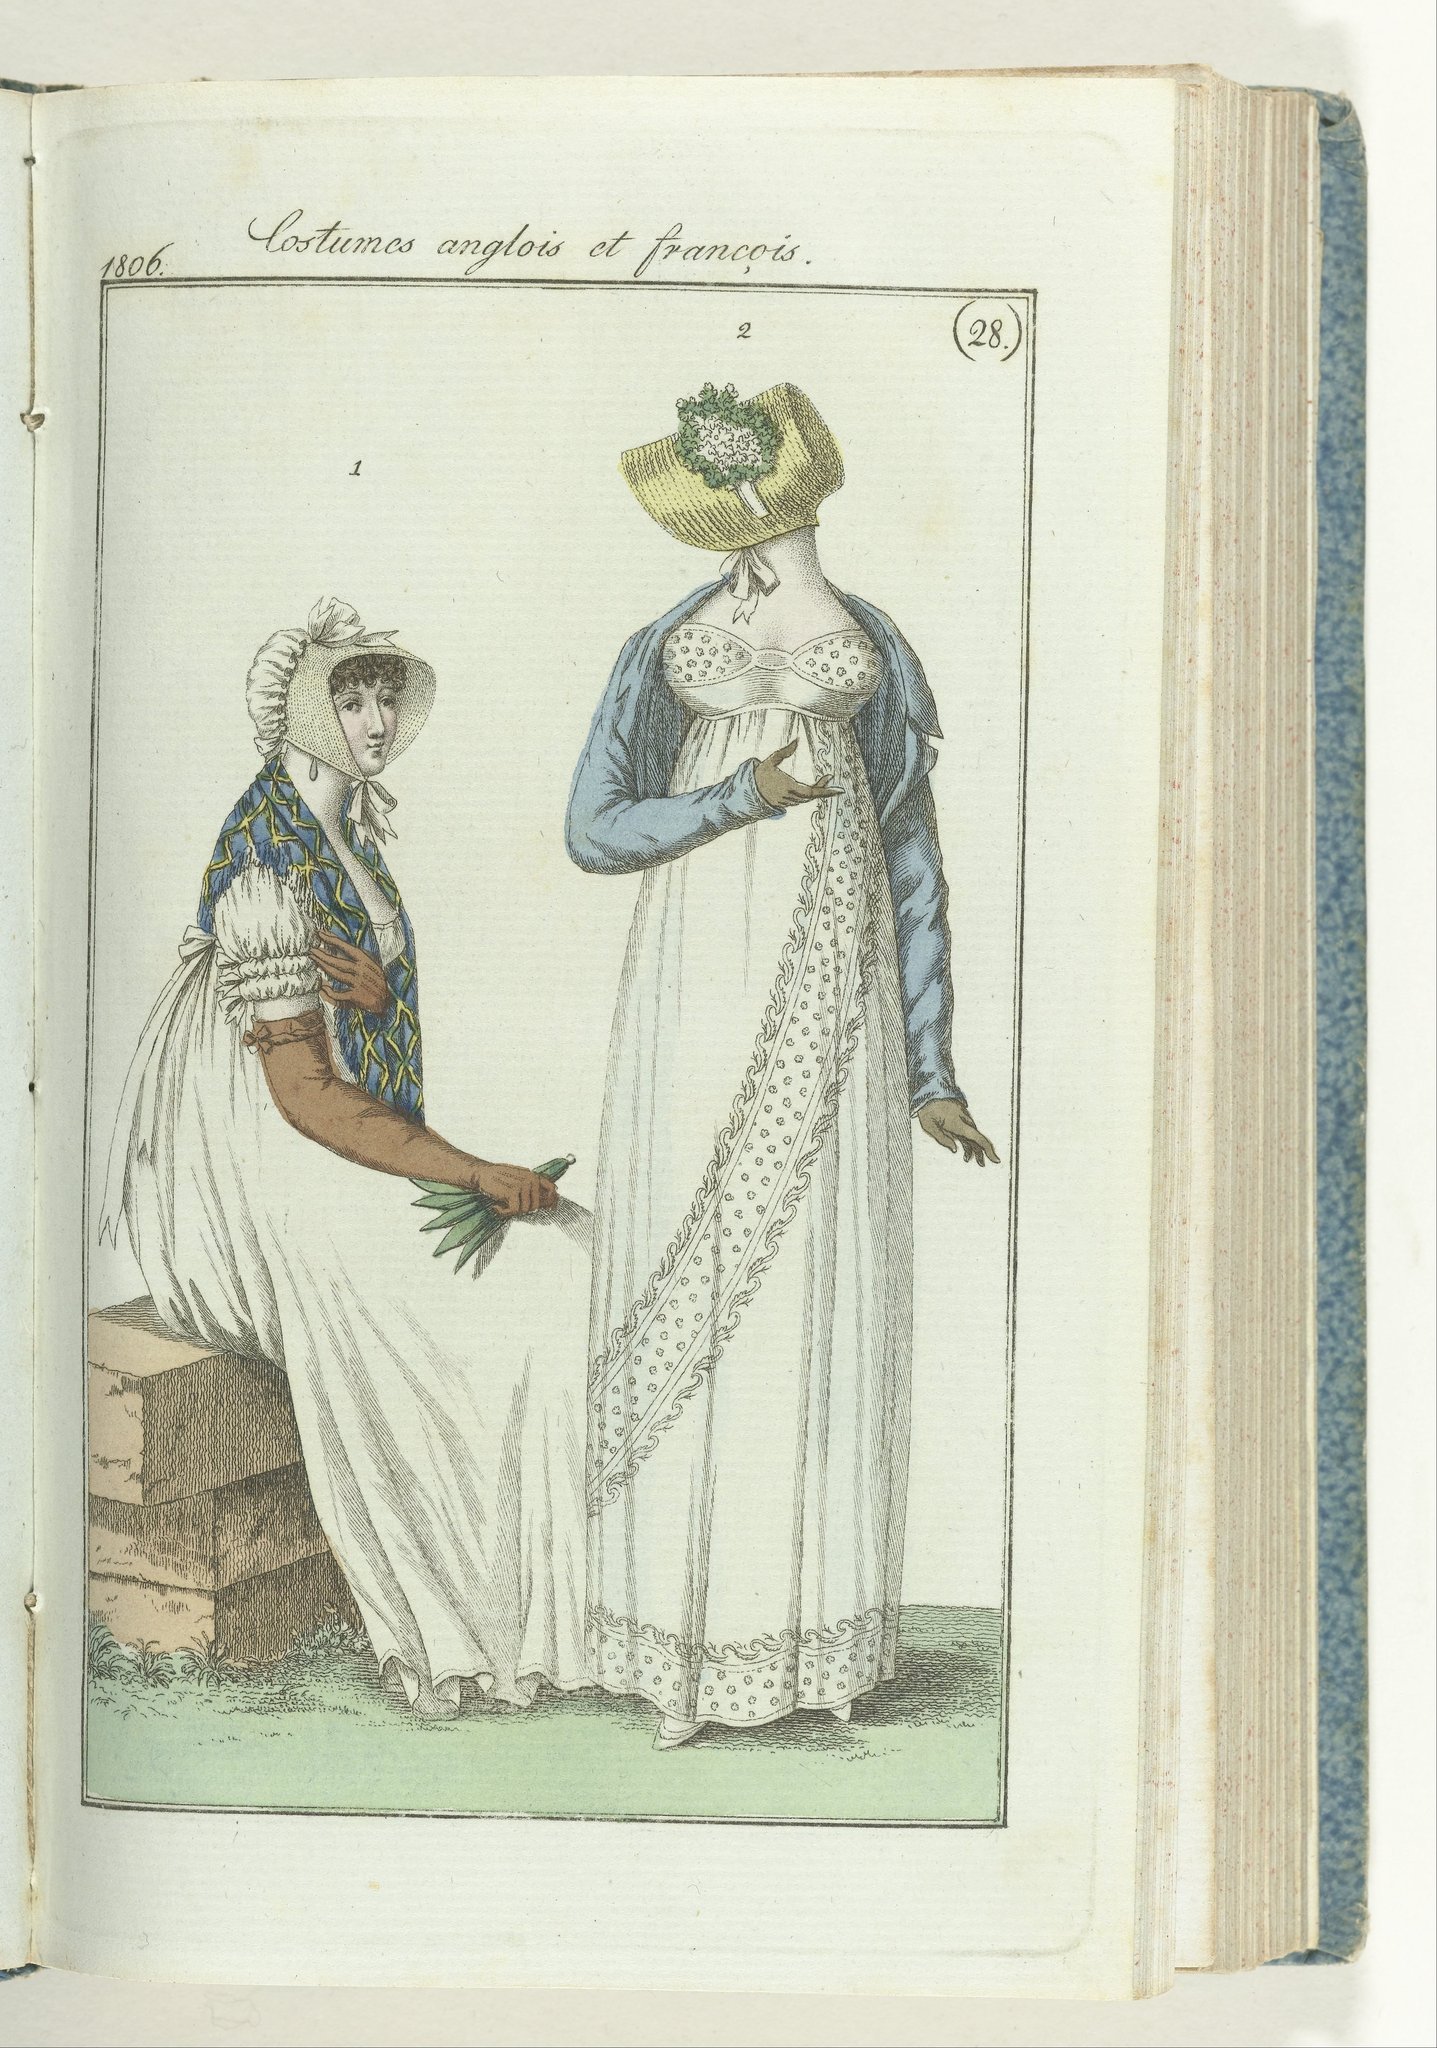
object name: magazine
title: Journal des dames et des modes, editie Frankfurt 7 juillet 1806, Costumes anglois et francois (28)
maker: j.p. lemaire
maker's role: publisher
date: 1806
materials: paper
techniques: engraving, hand coloring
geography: frankfurt am main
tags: head-gear (capote) (+ women's clothes), gloves, mittens (long gloves) (+ women's clothes), head-gear (cornette) (+ women's clothes), head-gear (bonnet a l'anglaise) (+ women's clothes), clothing for the upper part of the body (spencer) (+ women's clothes), head-gear: cap (+ women's clothes), fashion plates, clothes, costume (+ women's clothes), dress, gown (+ women's clothes), piece of clothing covering the breast or décolleté (fichu) (+ women's clothes)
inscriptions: title: ‘Costumes anglois et françois.’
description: Volgens de begeleidende tekst (p. 45): Fig. 1: Hoed met achterkant van tafzijde, geknoopt als cornet. Fichu van zijde. Japon van witte mousseline met korte pofmouwen. (Lange) handschoenen van leer. Groene schoenen. Fig. 2: Engelse mode: Bonnet 'à la chaumière', gegarneerd met meibloempjes. Korte japon van witte mousseline met een draperie die schuin van de taille naar de onderrand loopt. Draperie en en onderrand versierd met rijk geborduurde kant. Spencer van blauwe zijde. De prent maakt deel uit van het modetijdschrift Journal des Dames et des Modes, uitgegeven in Frankfurt als kopie van de Franse editie van Pierre de la Mésangère, (1798-1848).